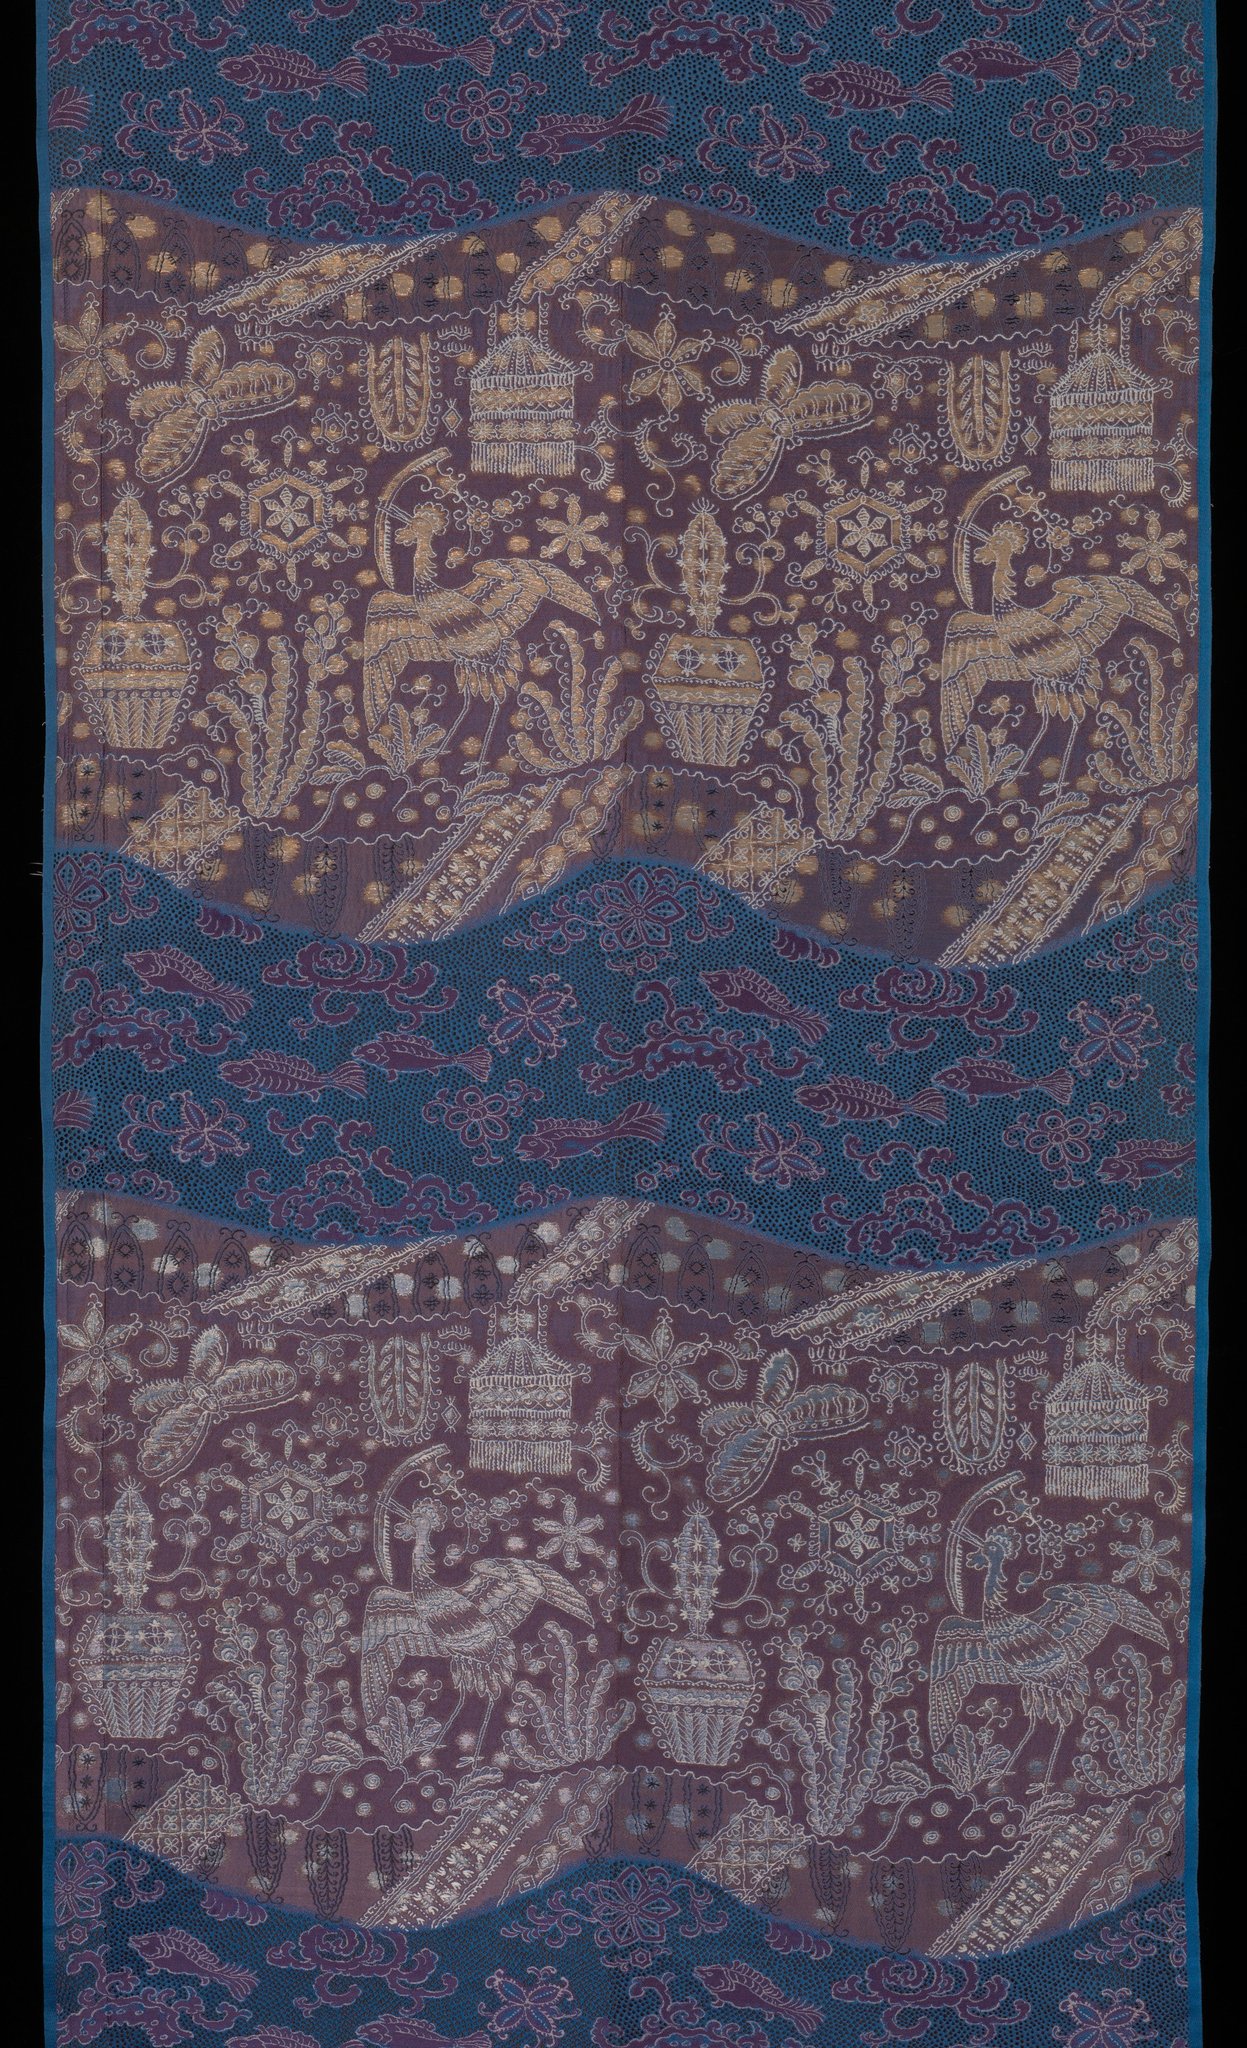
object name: obi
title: Obi with Design of Fish and Marine Objects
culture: japanese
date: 1912-1926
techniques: brocade, compound weave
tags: birds,fish,butterflies